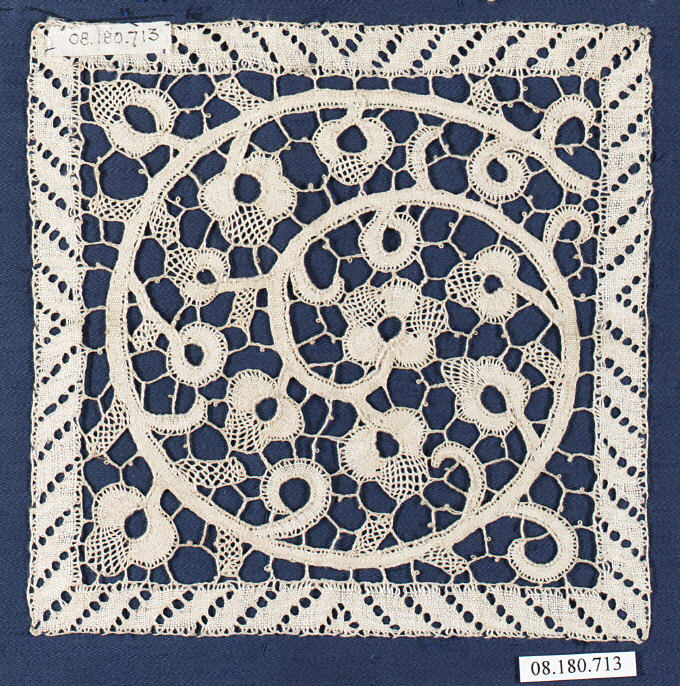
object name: square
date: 1801-1900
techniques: lace